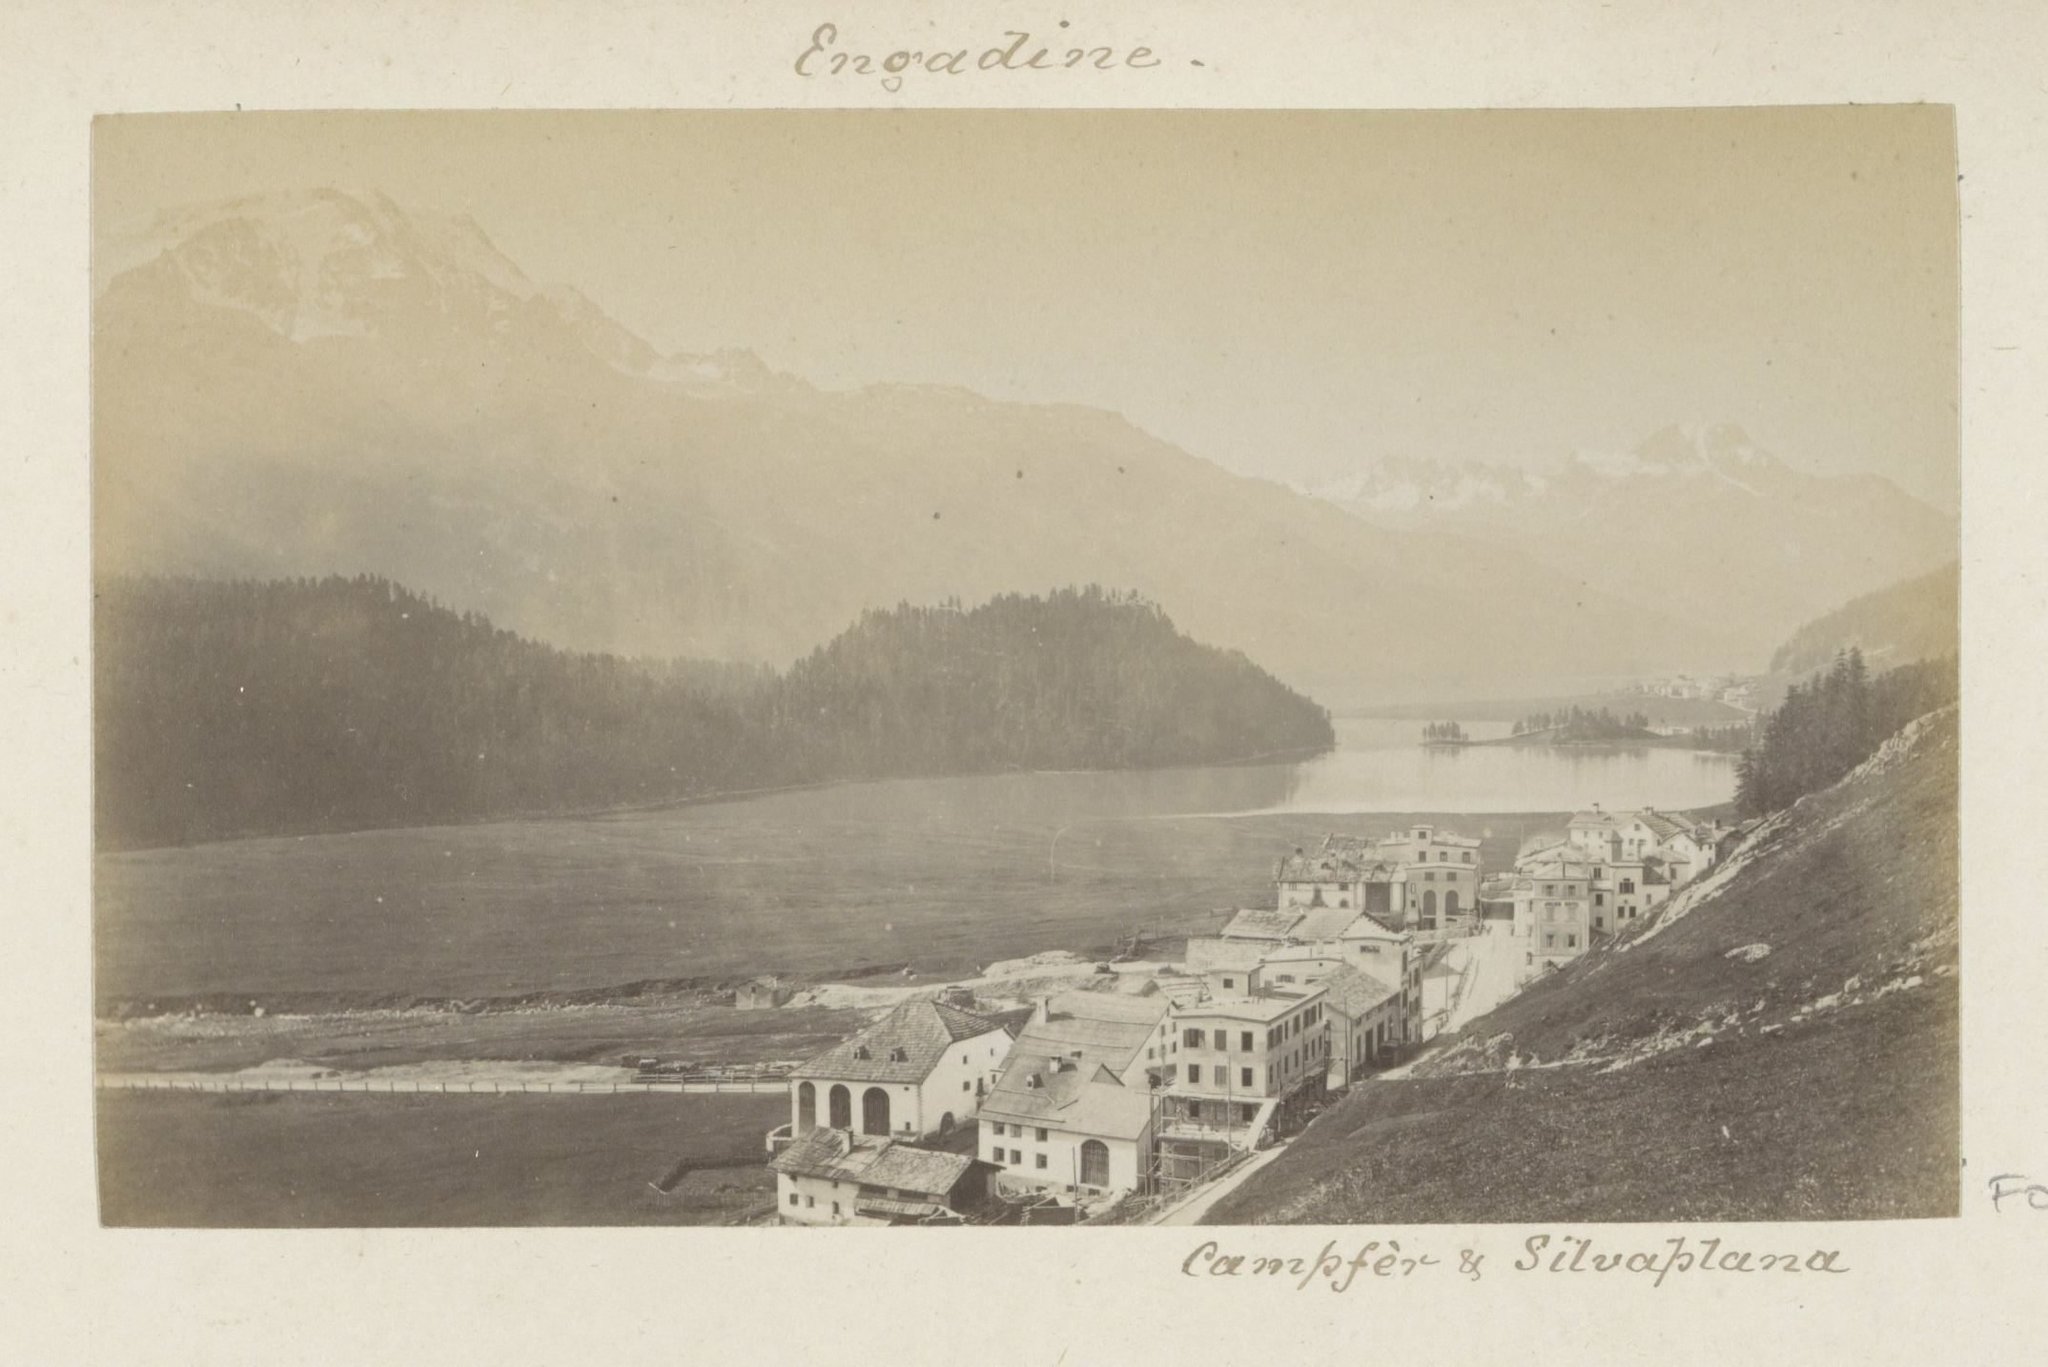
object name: photograph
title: Engadin Campfèr & Silvaplana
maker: Anonymous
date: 1860-1890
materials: paper, photographic support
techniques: albumen print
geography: switzerland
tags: prospect of village, silhouette of village, switzerland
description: Onderdeel van Reisalbum met foto's van Zwitserland, Oostenrijk, Italië en Duitsland.